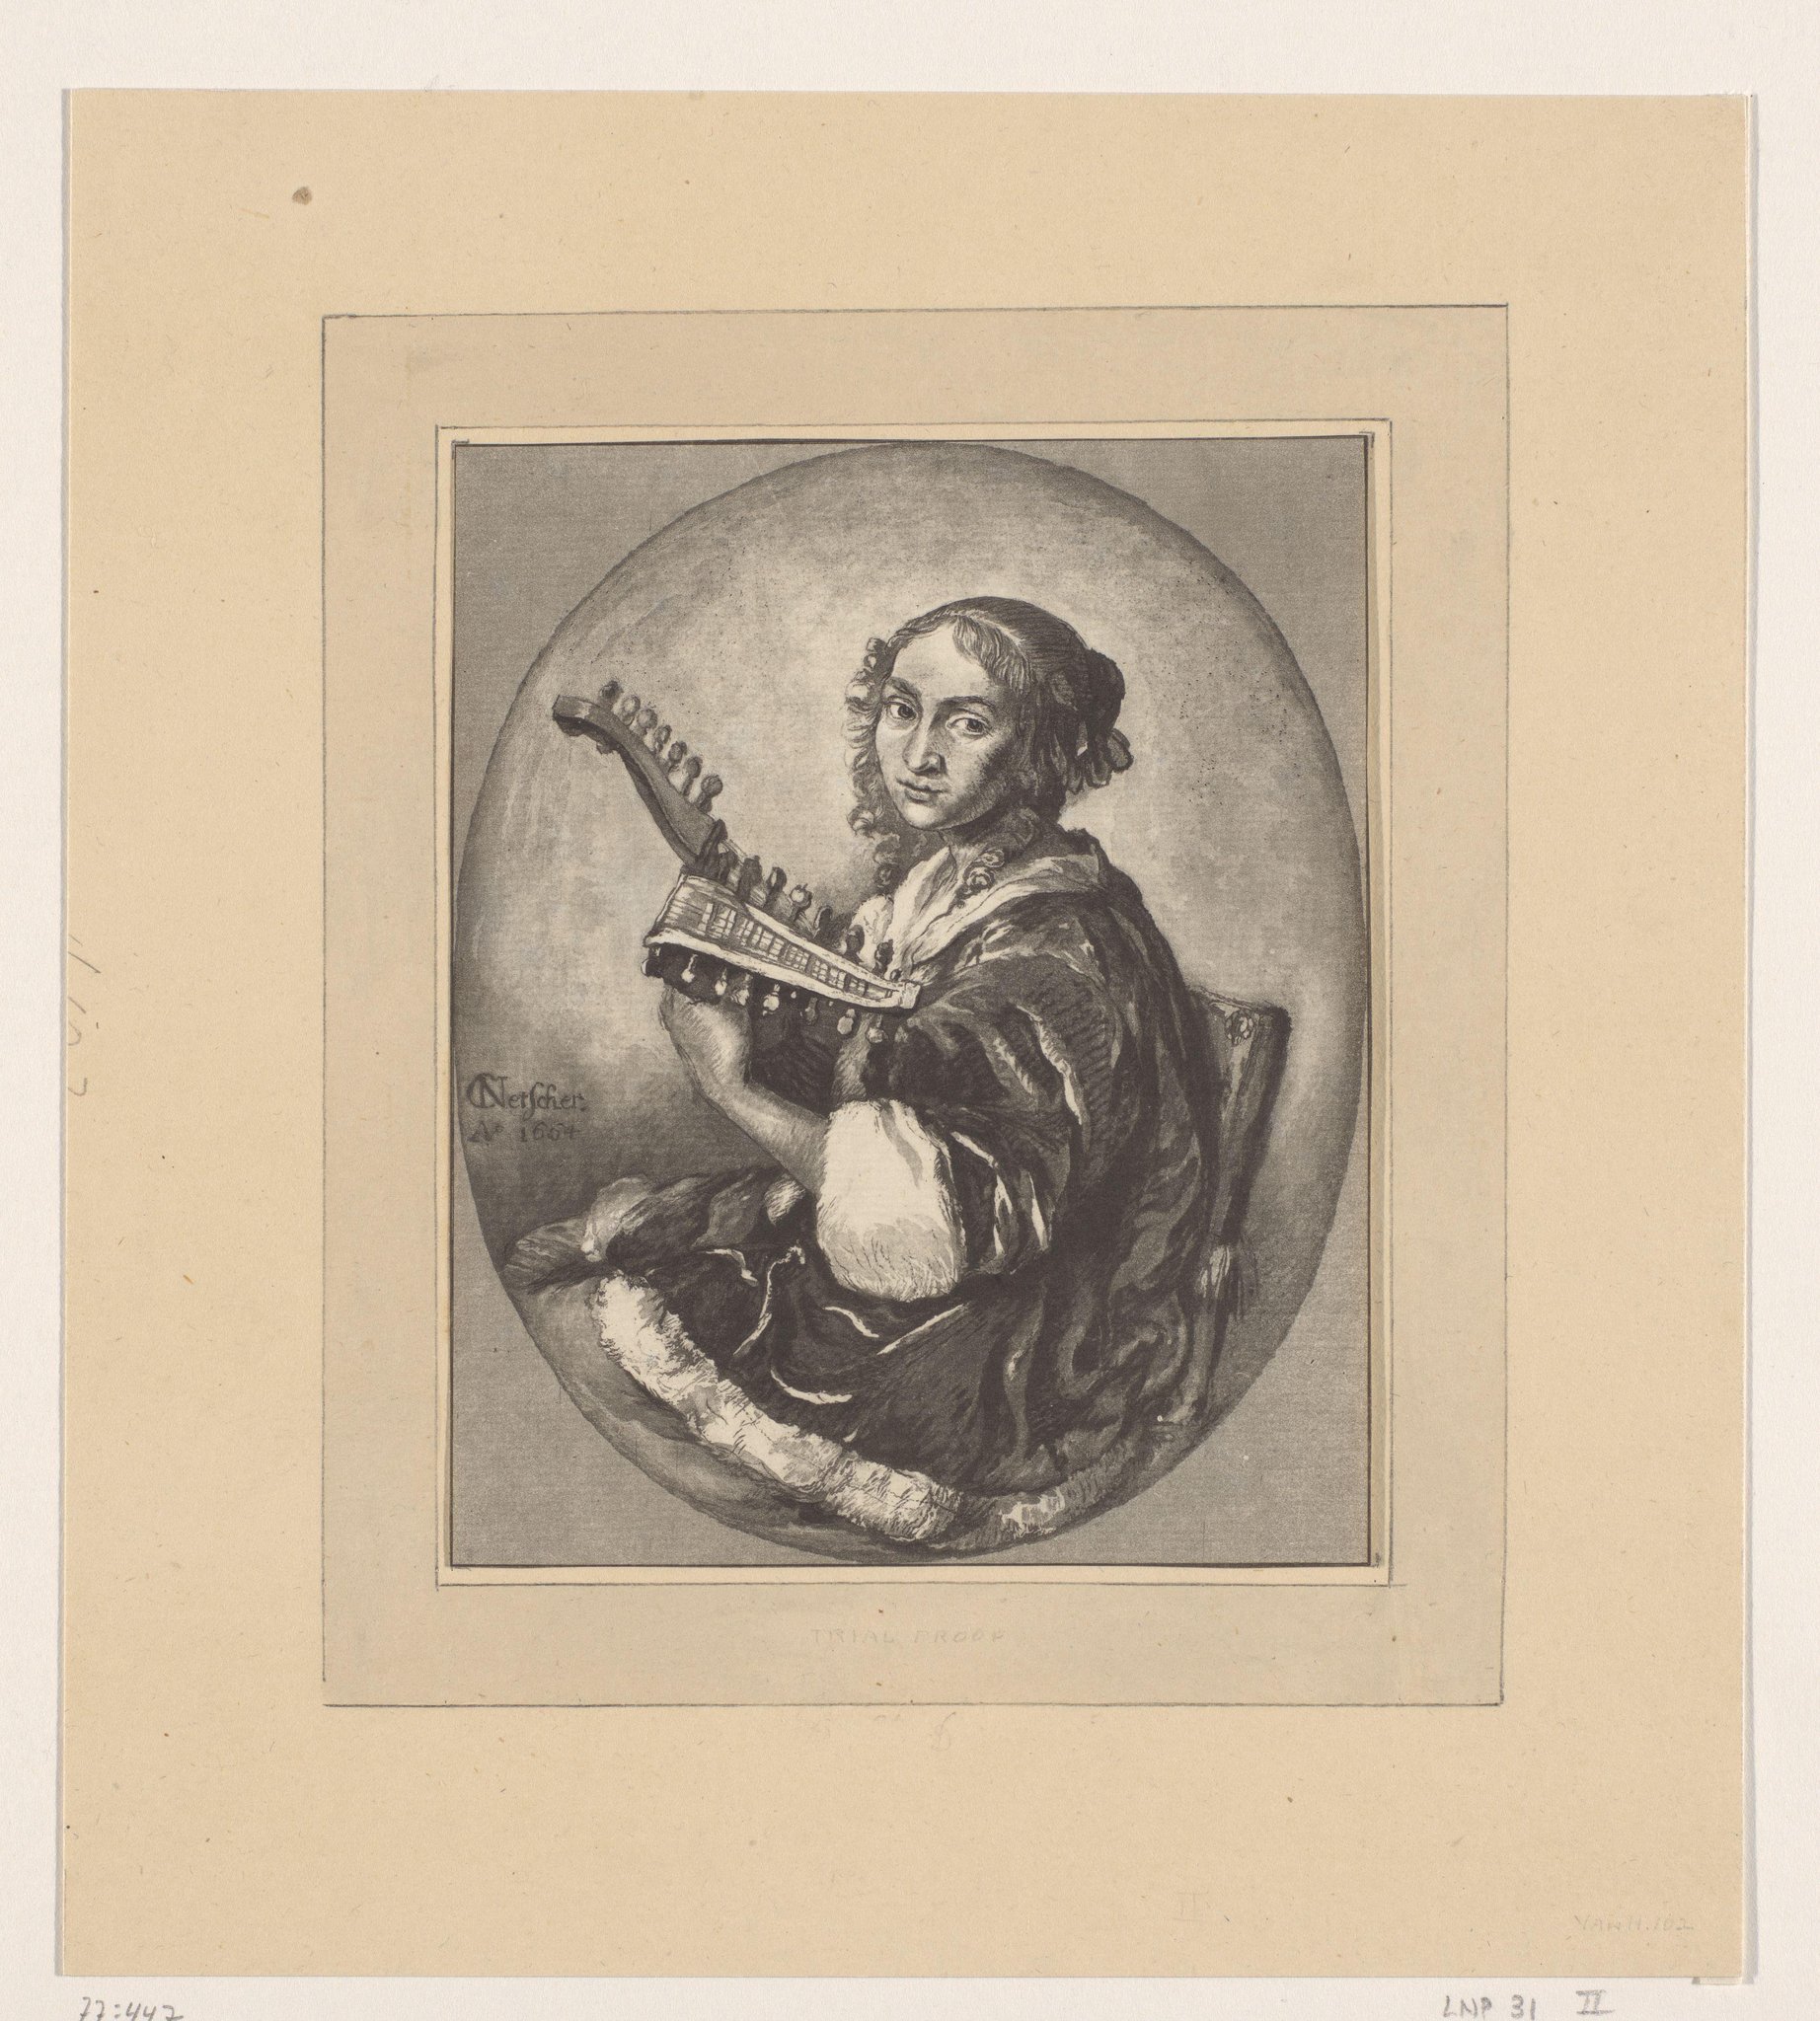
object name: print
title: Luitspeelster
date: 1781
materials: paper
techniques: transfer, print drawing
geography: amsterdam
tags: string instruments (plucked)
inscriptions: collector's mark: Lugt 2725, collector's mark: Lugt 2228